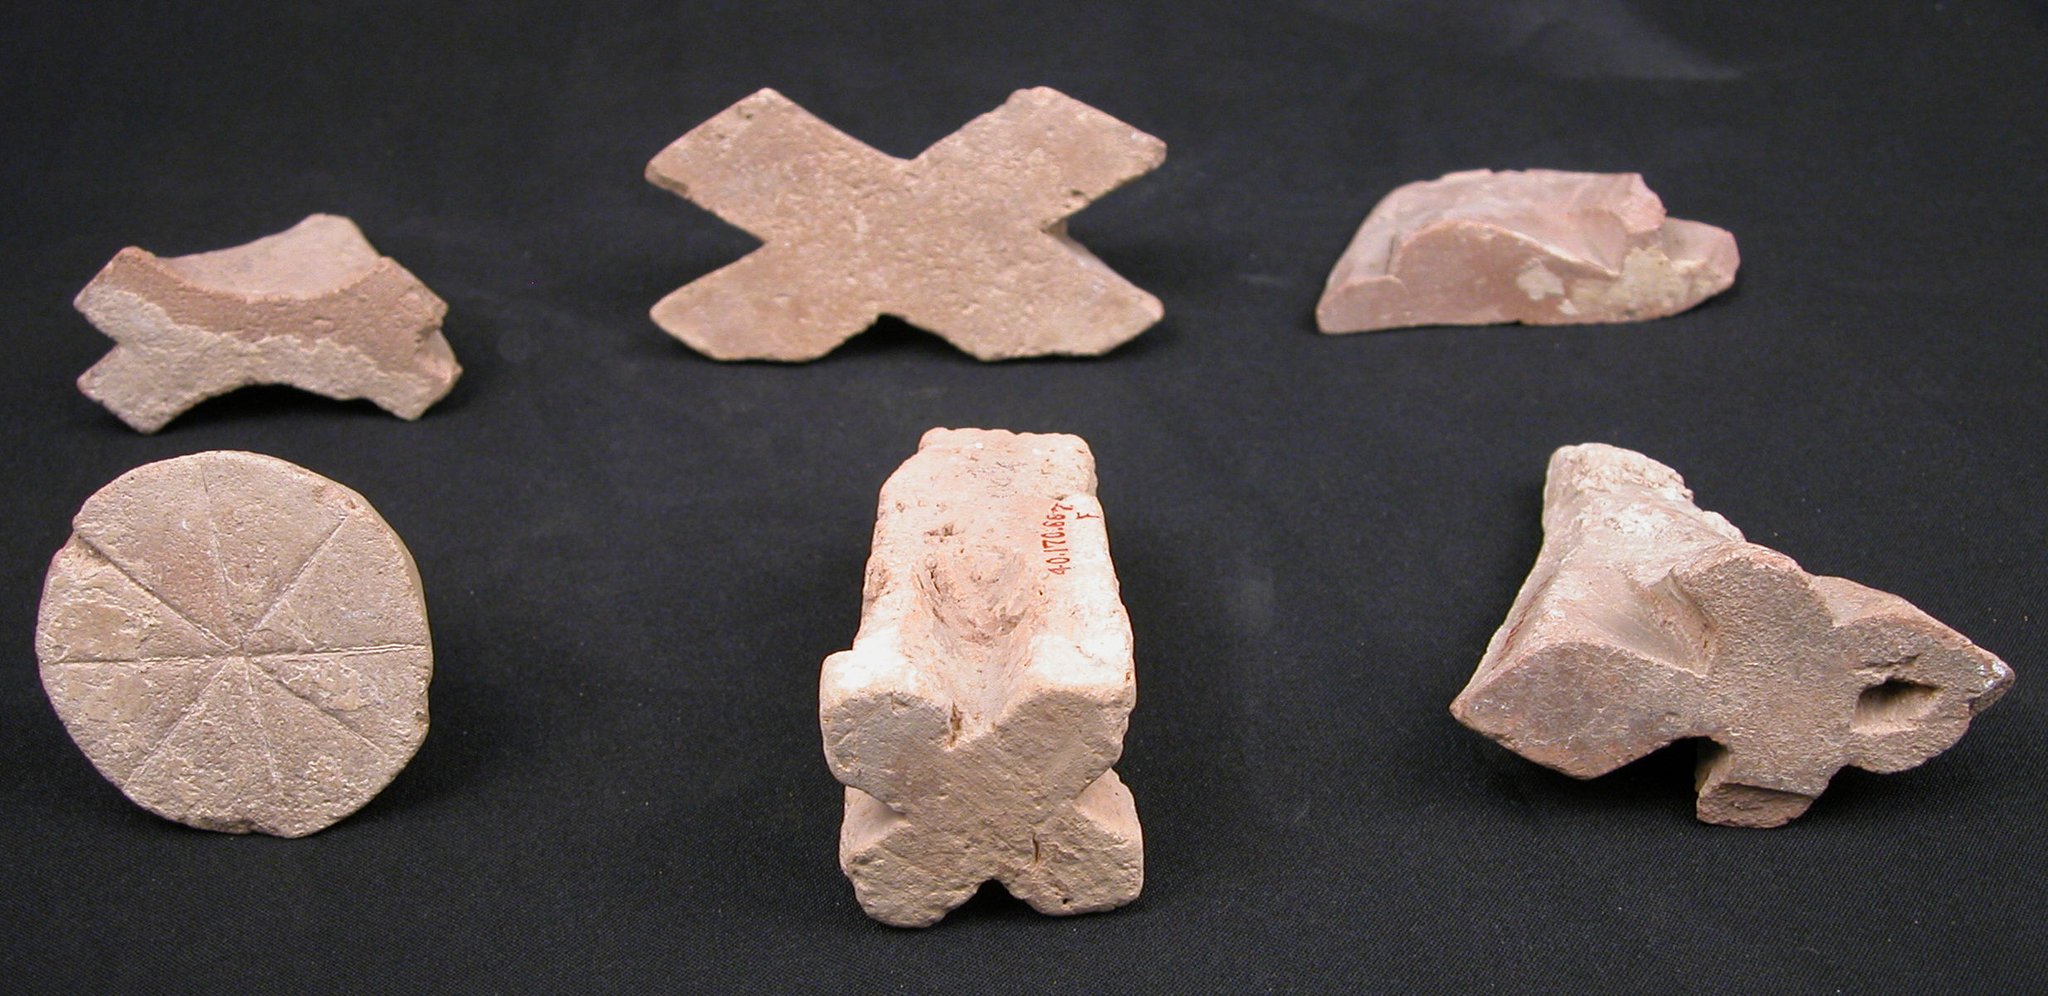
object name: ornament architecture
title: Architectural Ornament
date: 1001-1100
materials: earthenware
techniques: carving, painting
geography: iran